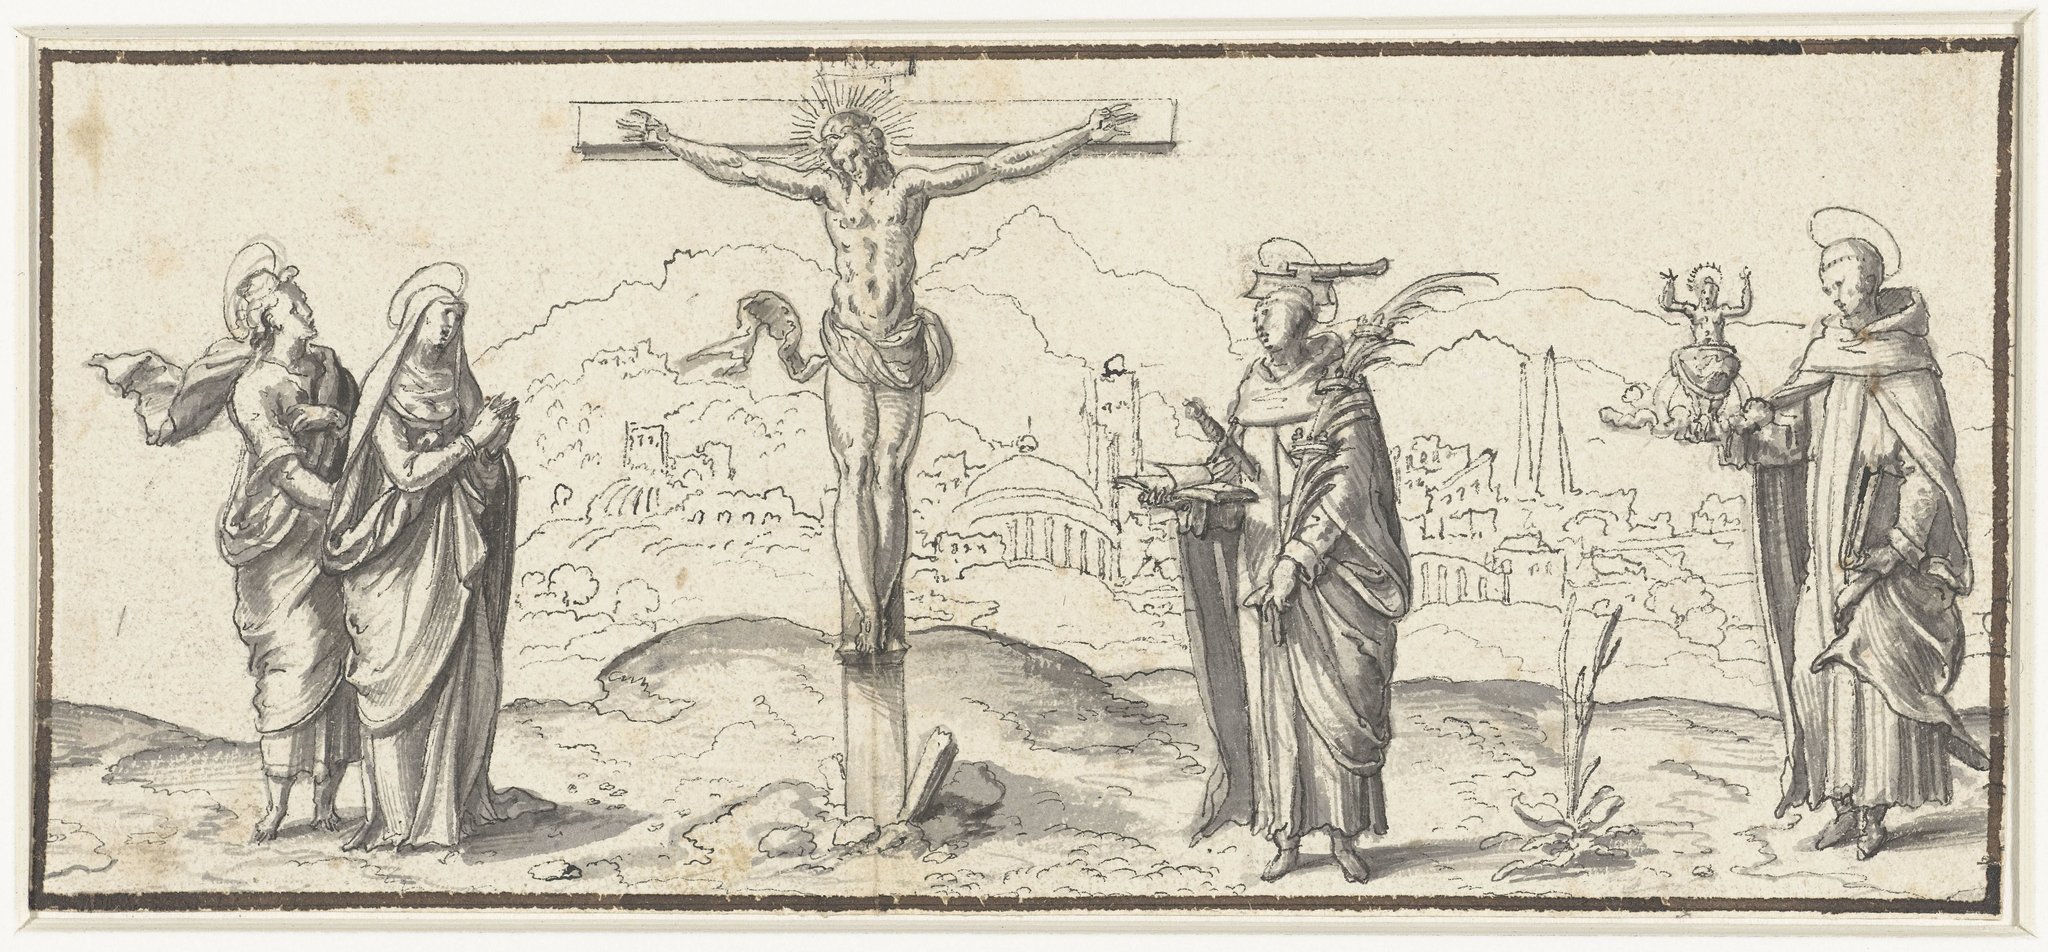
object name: drawing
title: Christus aan het kruis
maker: Anonymous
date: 1550-1599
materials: ink, paper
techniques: brush, pen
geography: southern germany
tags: the dominican friar peter martyr of verona; possible attributes: crucifix, finger at lips, palm, sword (axe or knife) in skull (or breast), wound in head, crucified christ with other persons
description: Christus aan het kruis, links Maria en Johannes, rechts H. Petrus Martyr en een onbekende mannelijke heilige.